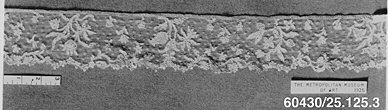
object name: edging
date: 1701-1800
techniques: lace